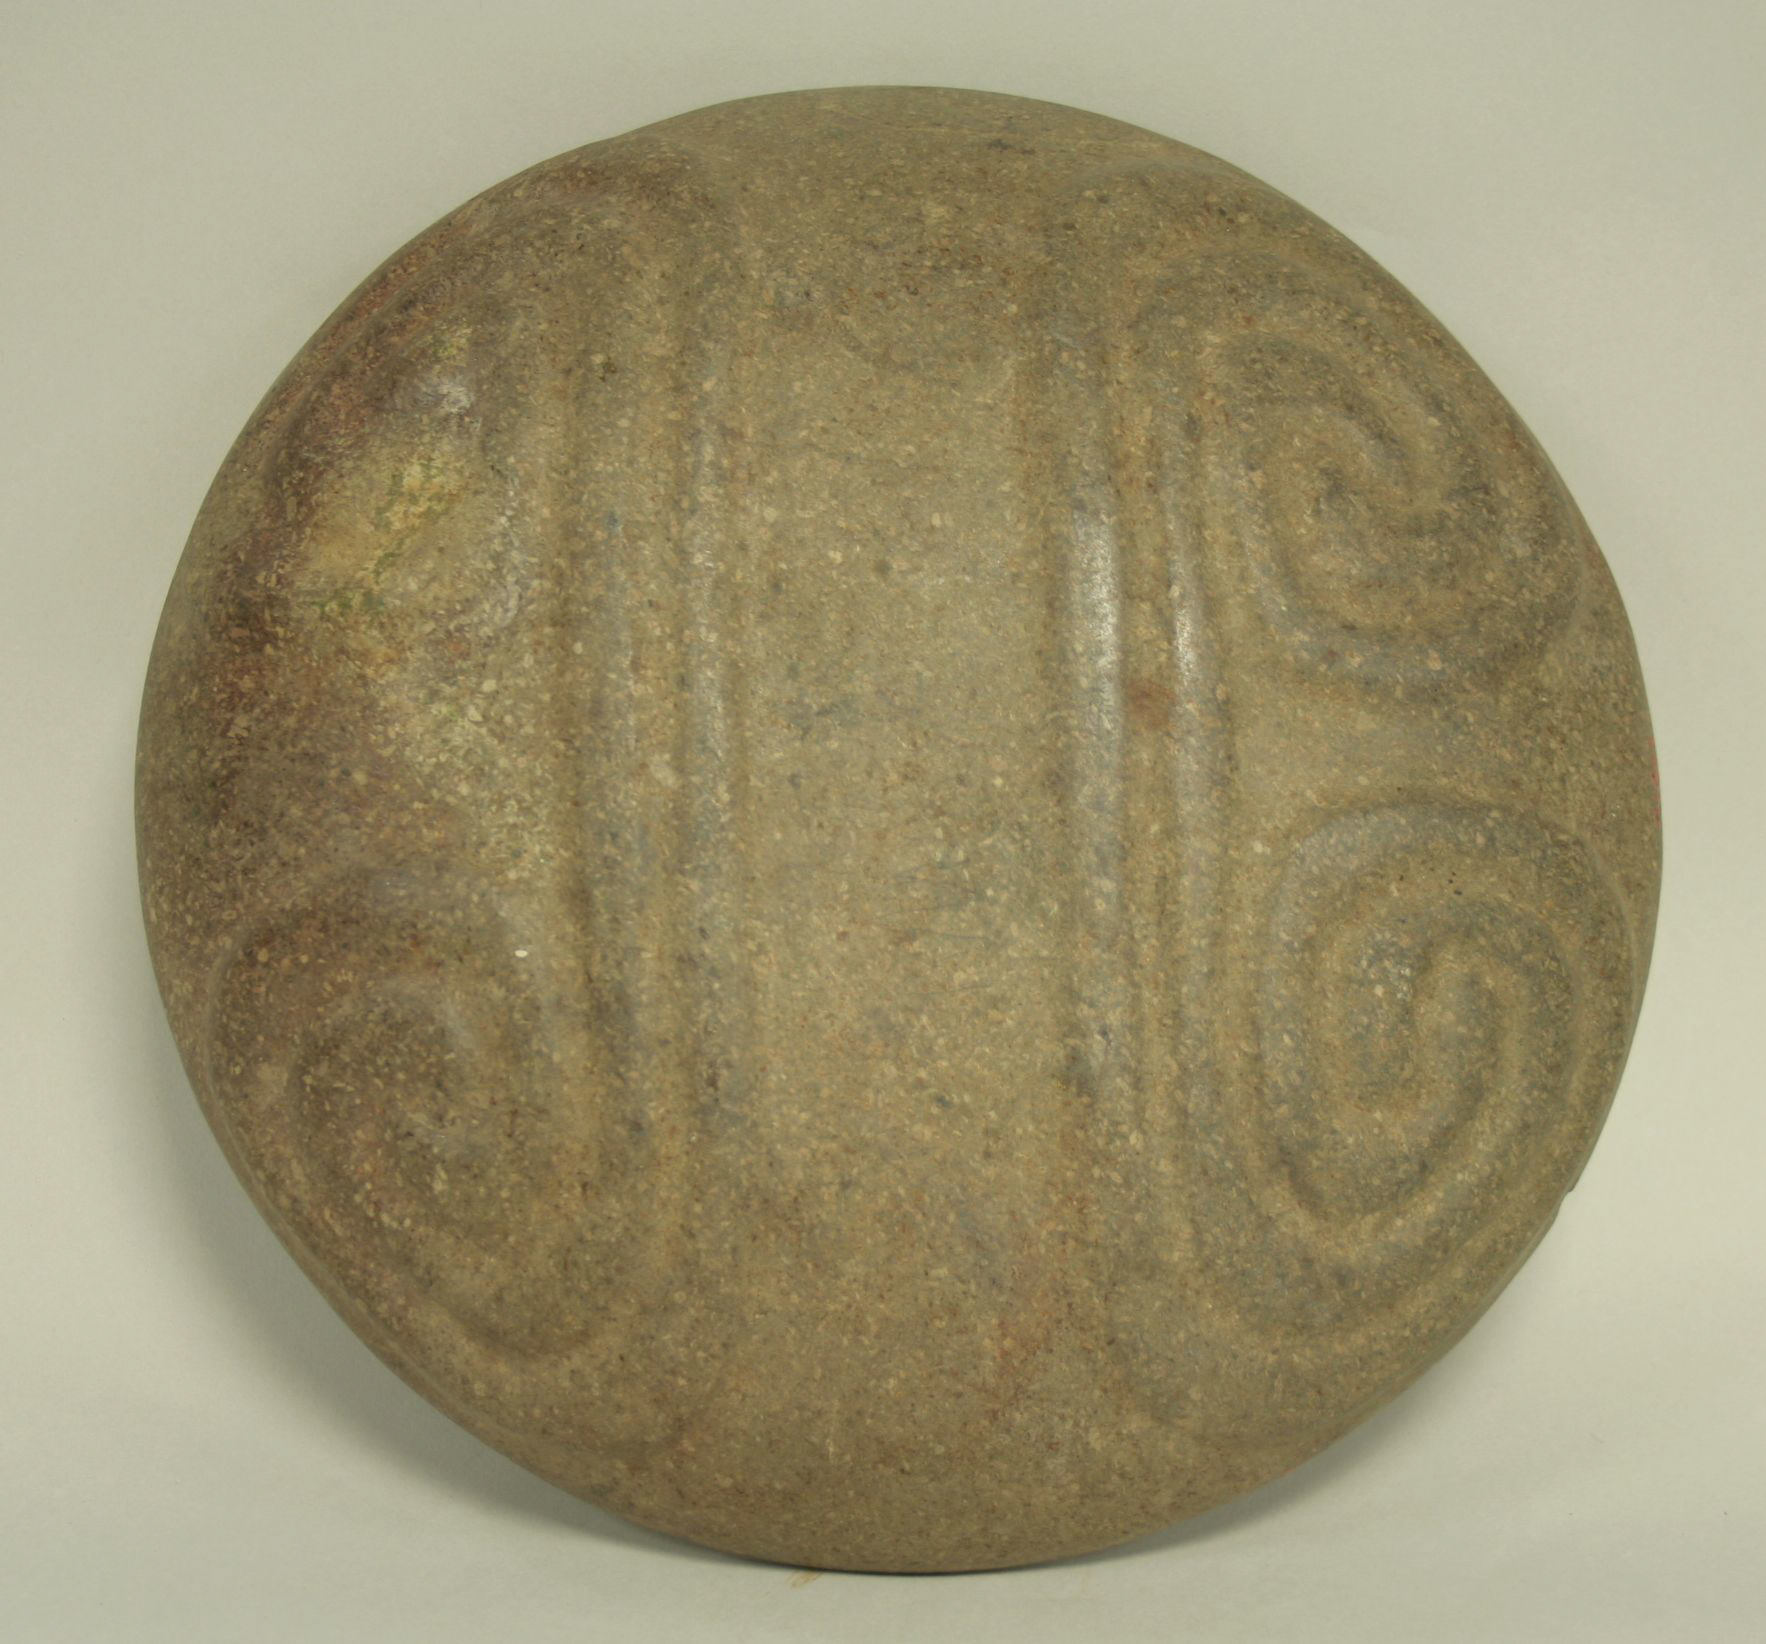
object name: plate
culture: south highlands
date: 1401-1500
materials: stone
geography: peru